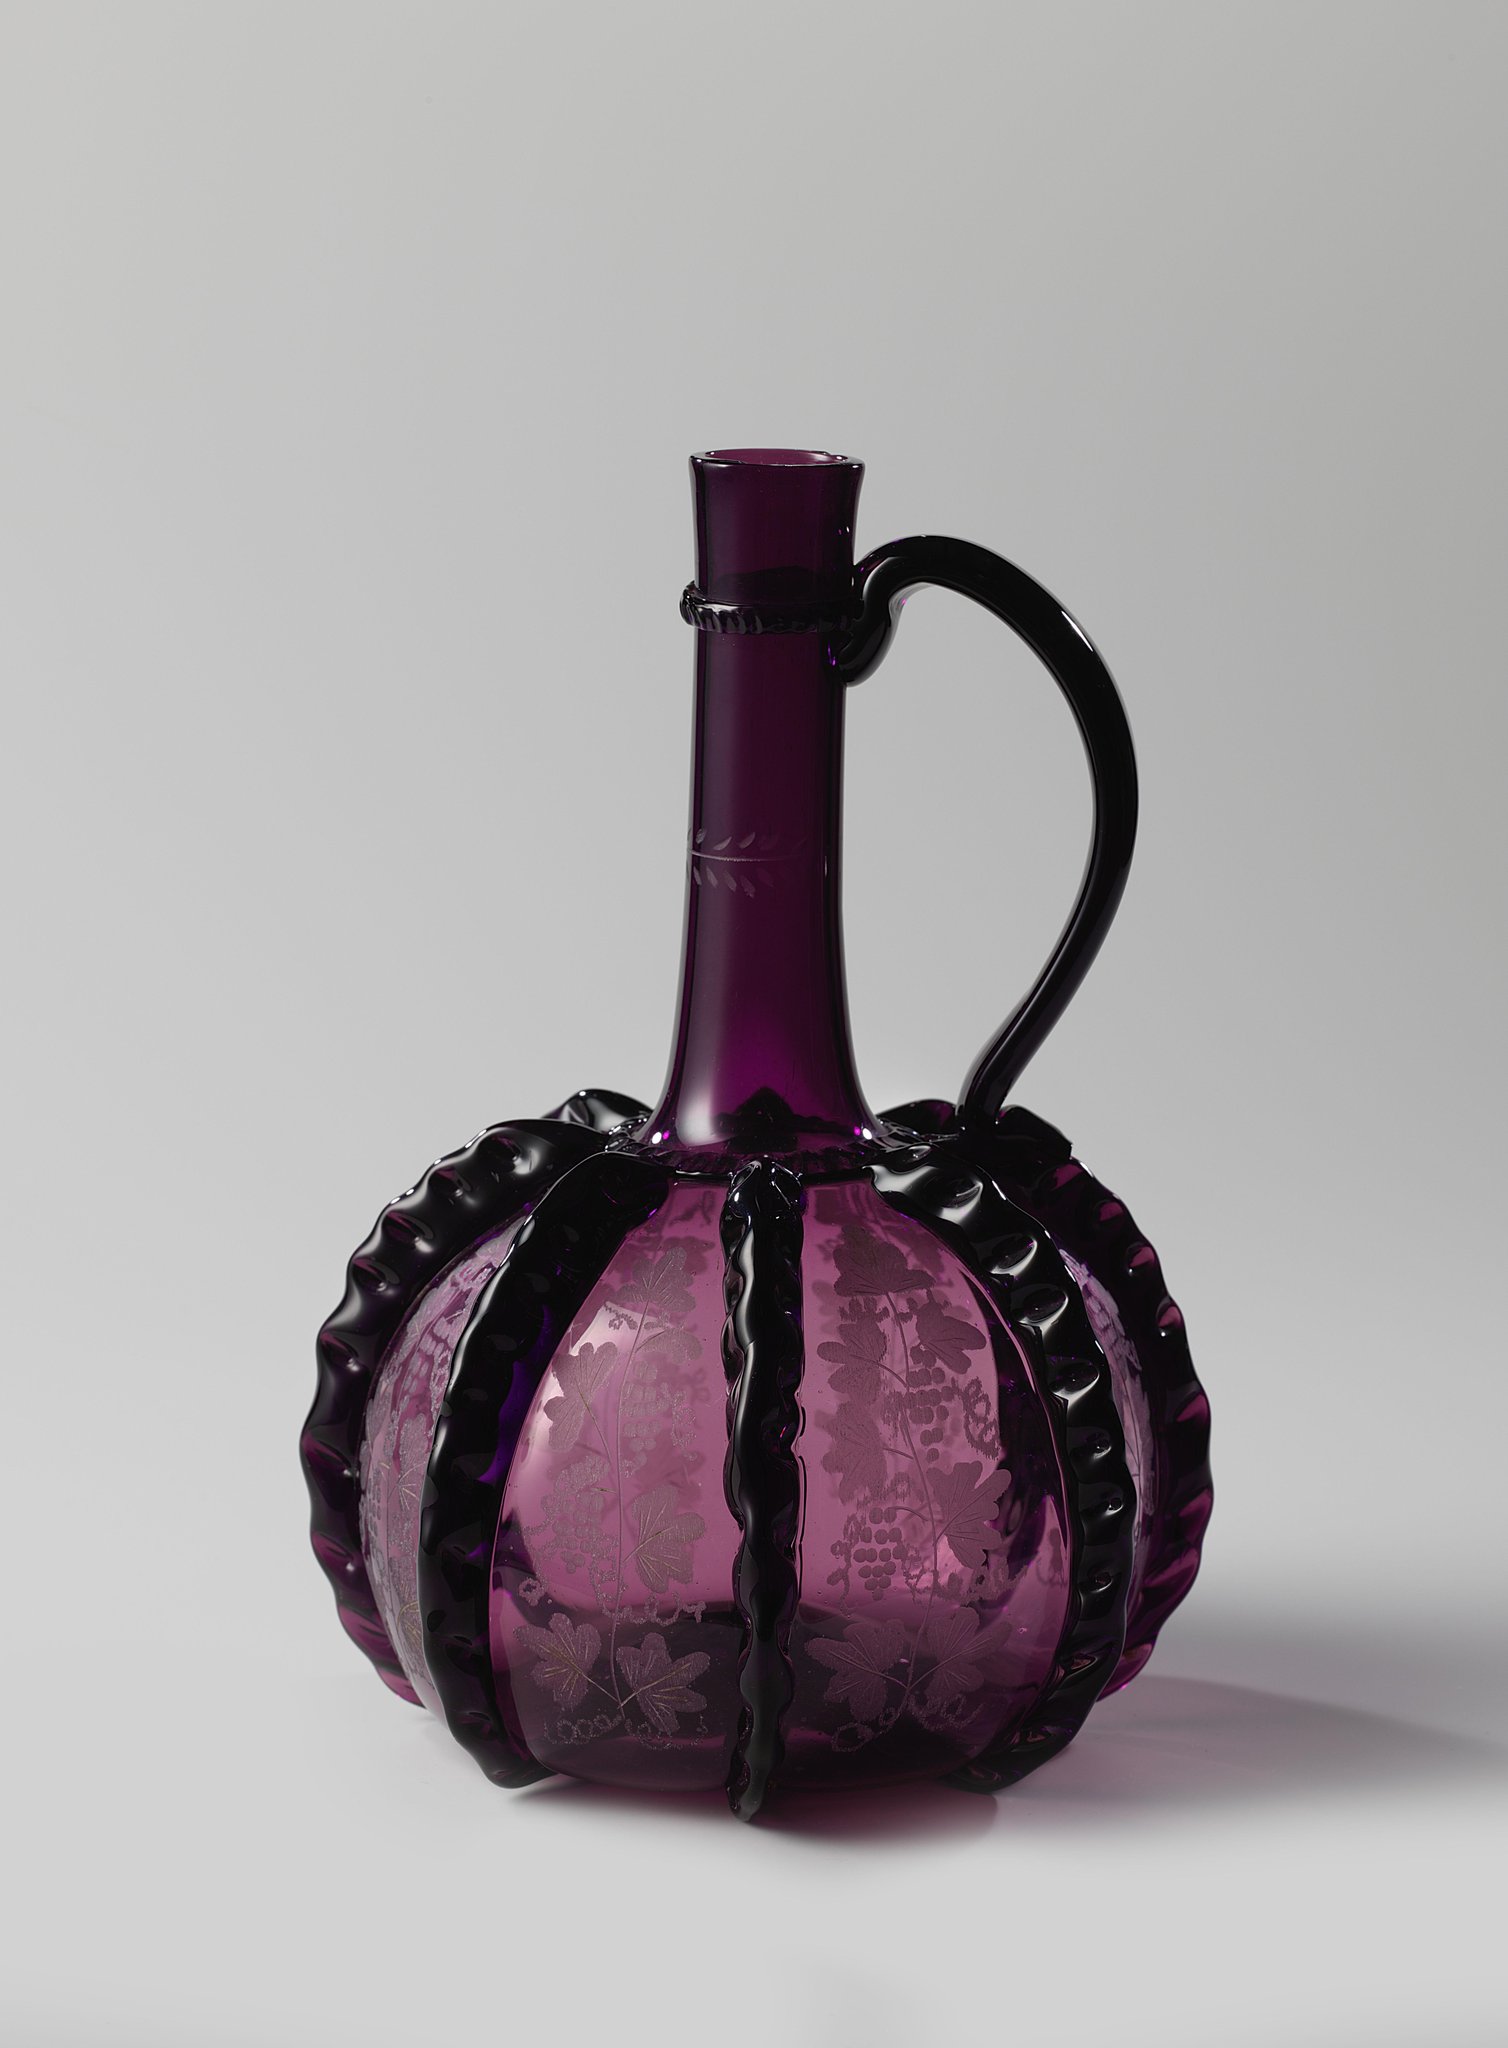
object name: carafe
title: Karaf met wijnranken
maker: Anonymous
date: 1700-1725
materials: glass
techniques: glassblowing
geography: northern netherlands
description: Karaf van paars glas. Ingestoken ziel. Bolvormig lichaam met zes geknepen ribben. Rechte hals. C-vormig handvat. Op het lichaam zijn met het rad tussen de ribben wijnranken gegraveerd.